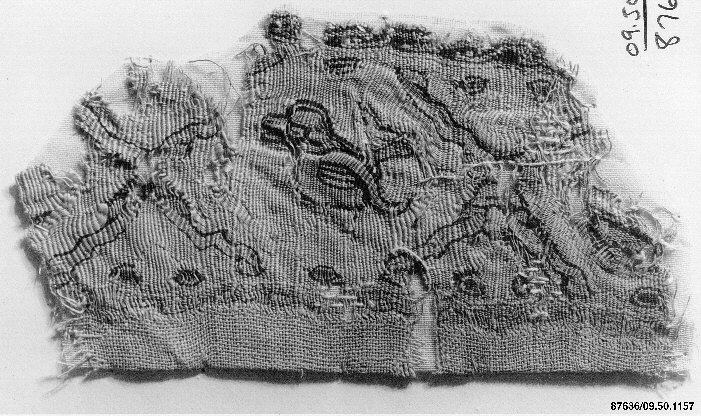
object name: textile fragment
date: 901-1000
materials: linen, silk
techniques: weave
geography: egypt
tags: birds